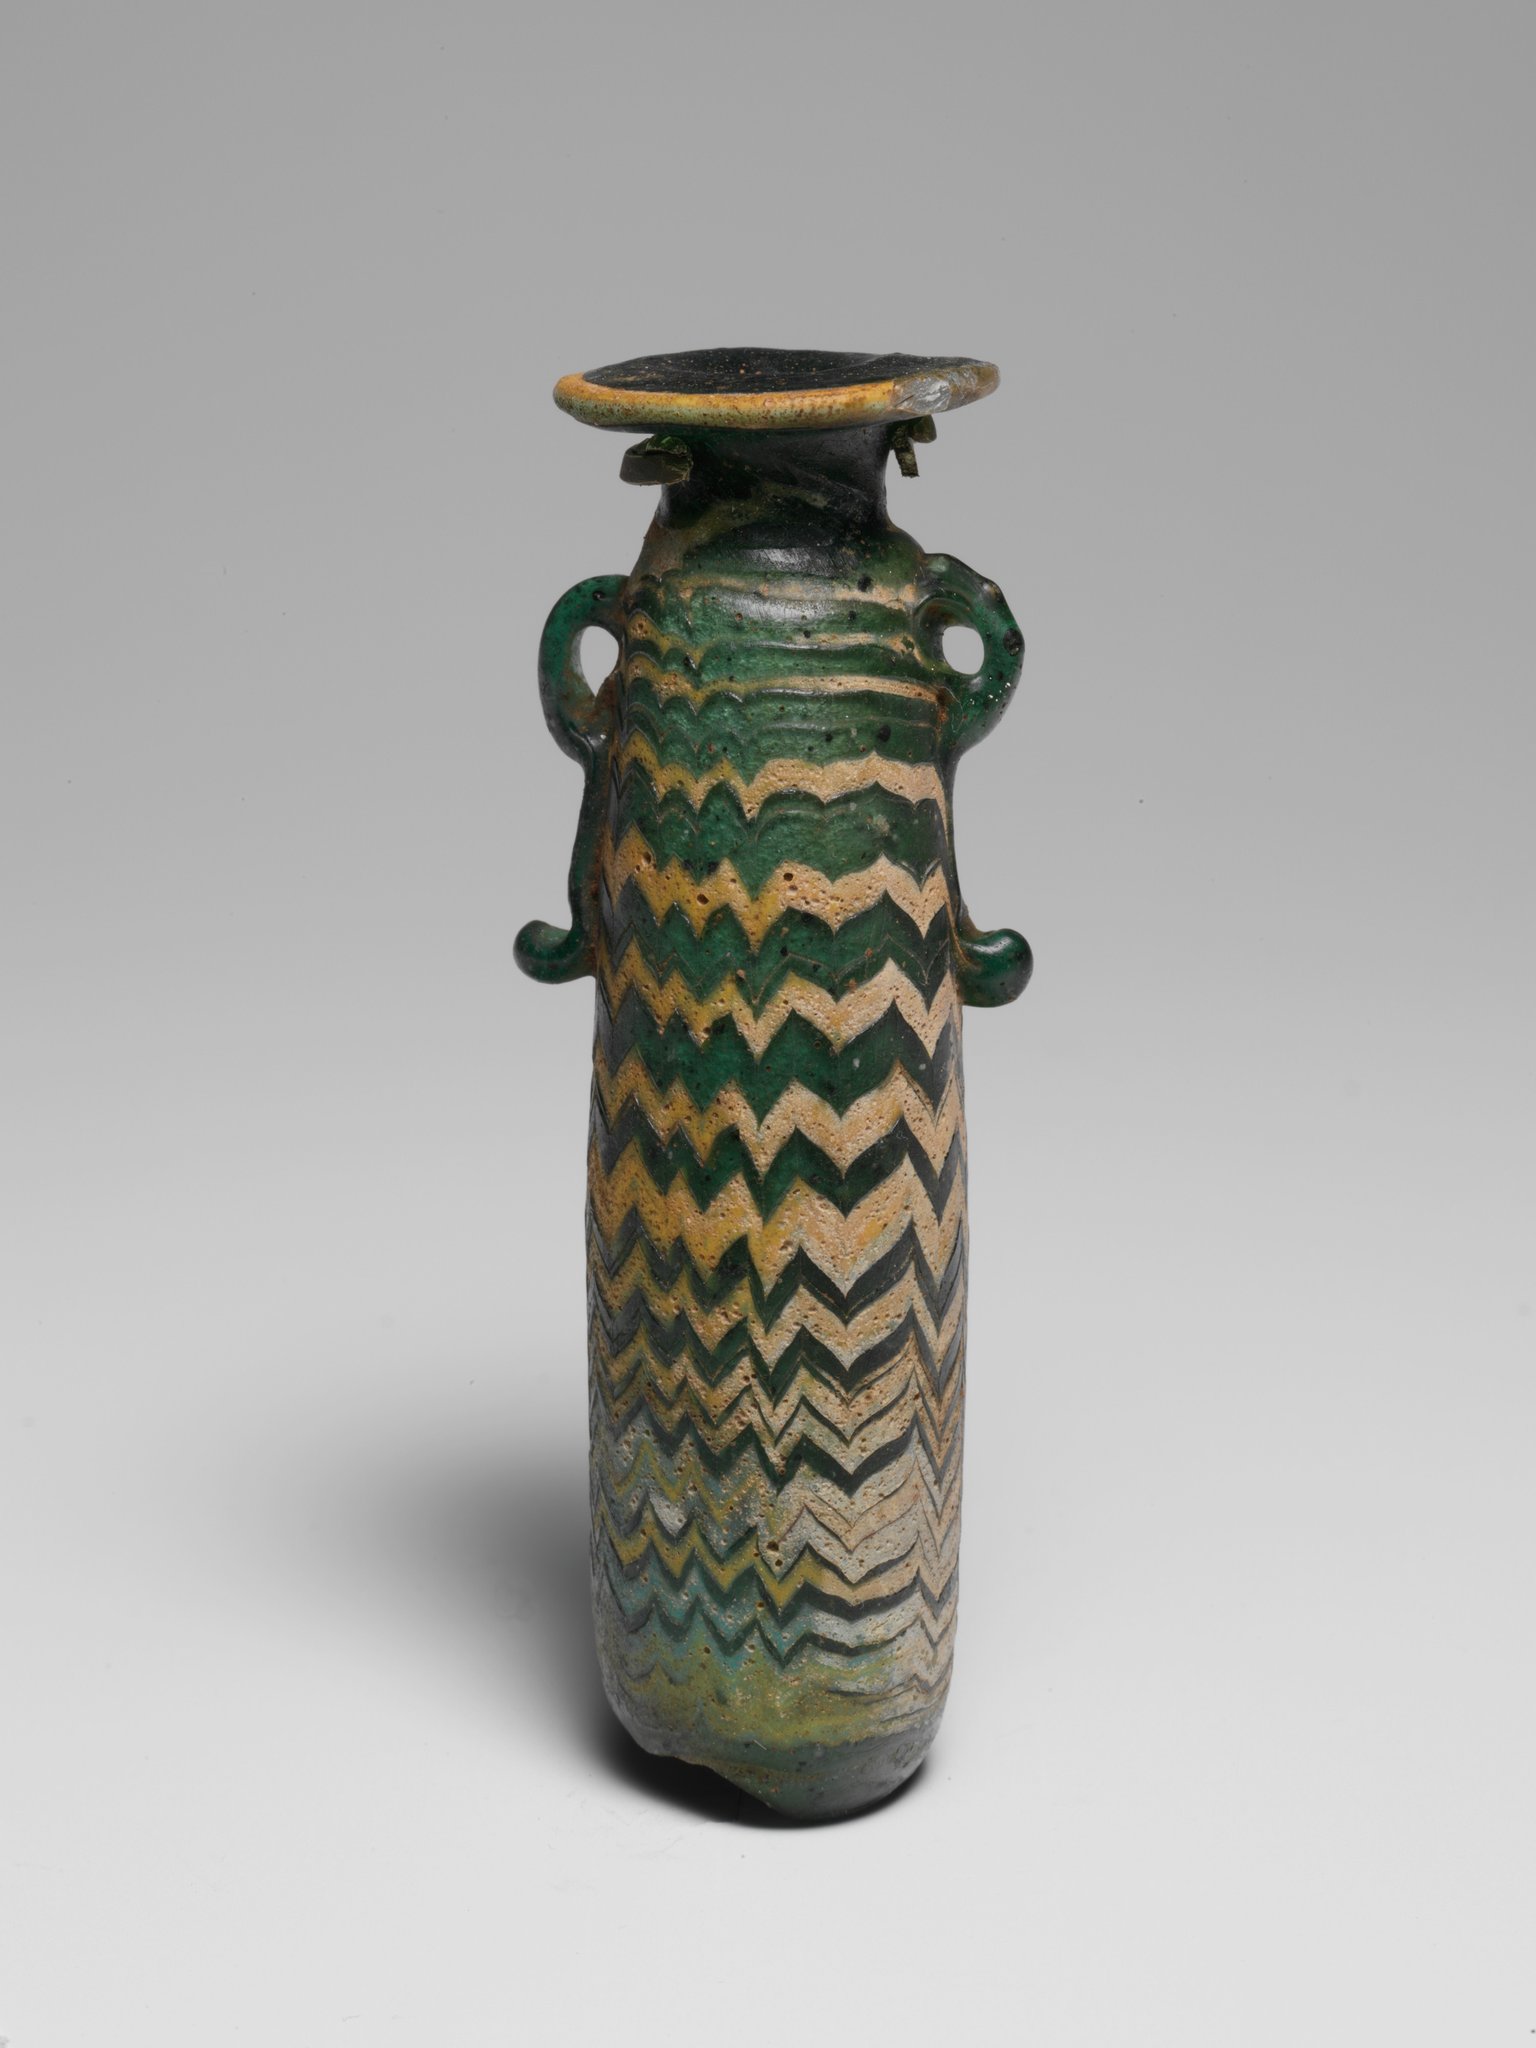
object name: alabastron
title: Glass alabastron (perfume bottle)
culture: greek, eastern mediterranean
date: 500-401 BCE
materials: glass